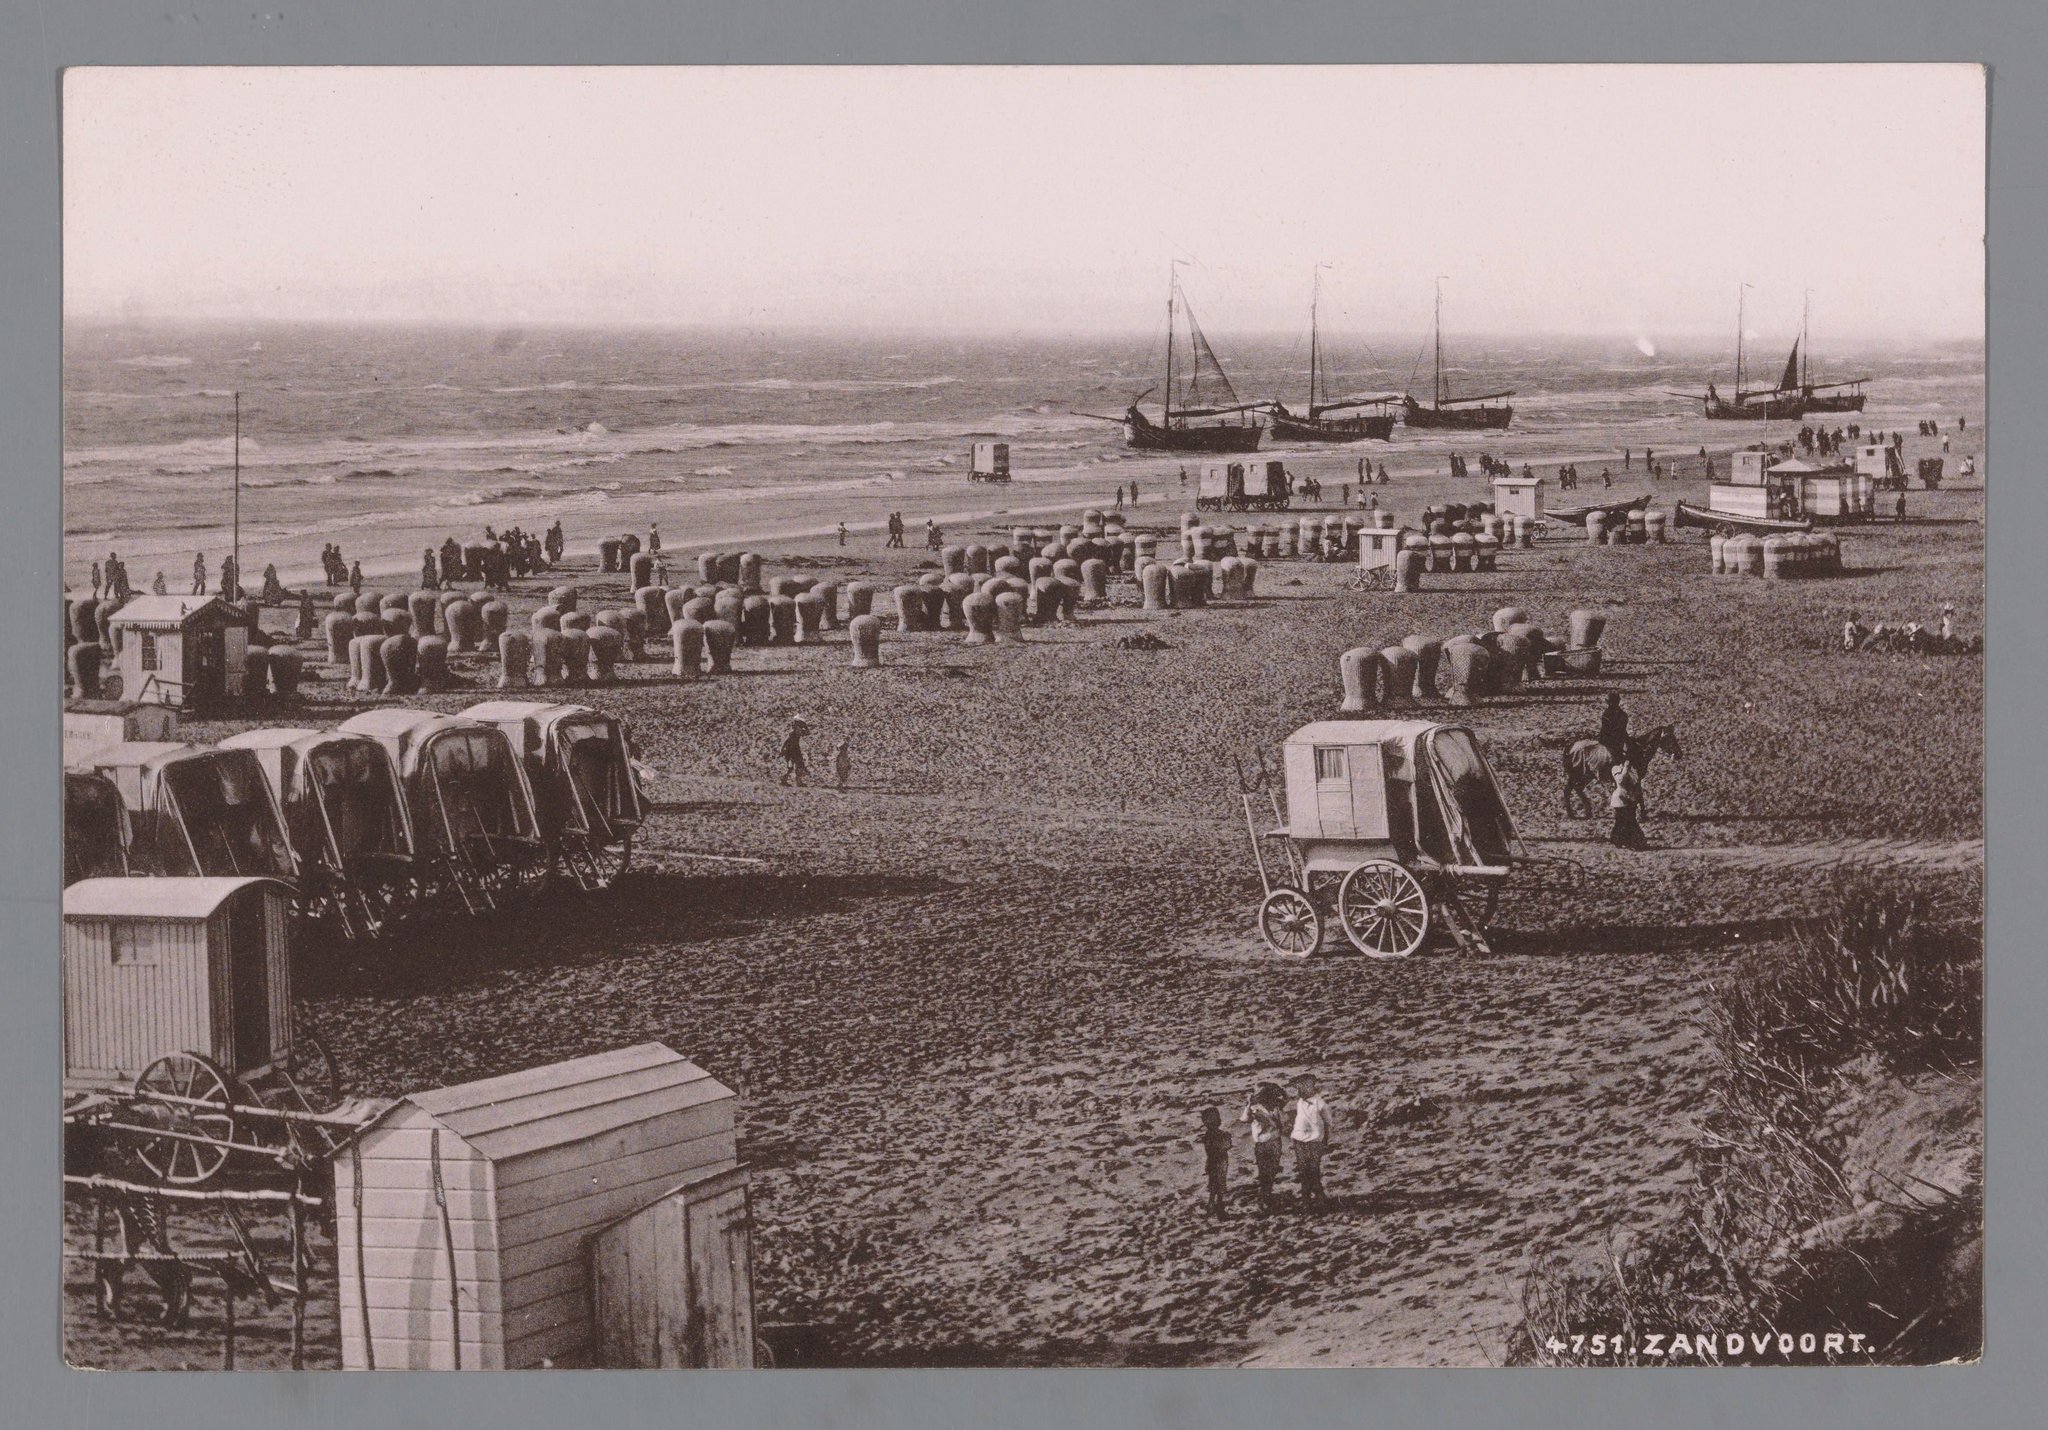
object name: photomechanical print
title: Strandgezicht met huifkarren en rieten strand- stoelen te Zandvoort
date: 1875-1930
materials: paper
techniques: photograph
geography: zandvoort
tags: covered wagon, hooded wagon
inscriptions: number: ‘4751. Zandvoort’, retailer's mark: ‘Boek-, Papier, Muziekhandel/ en aanverwante artikelen/ H. Goebergh/ Grote Houtstraat/ Haarlem’, retailer's mark: ‘Römmler & Jonas’